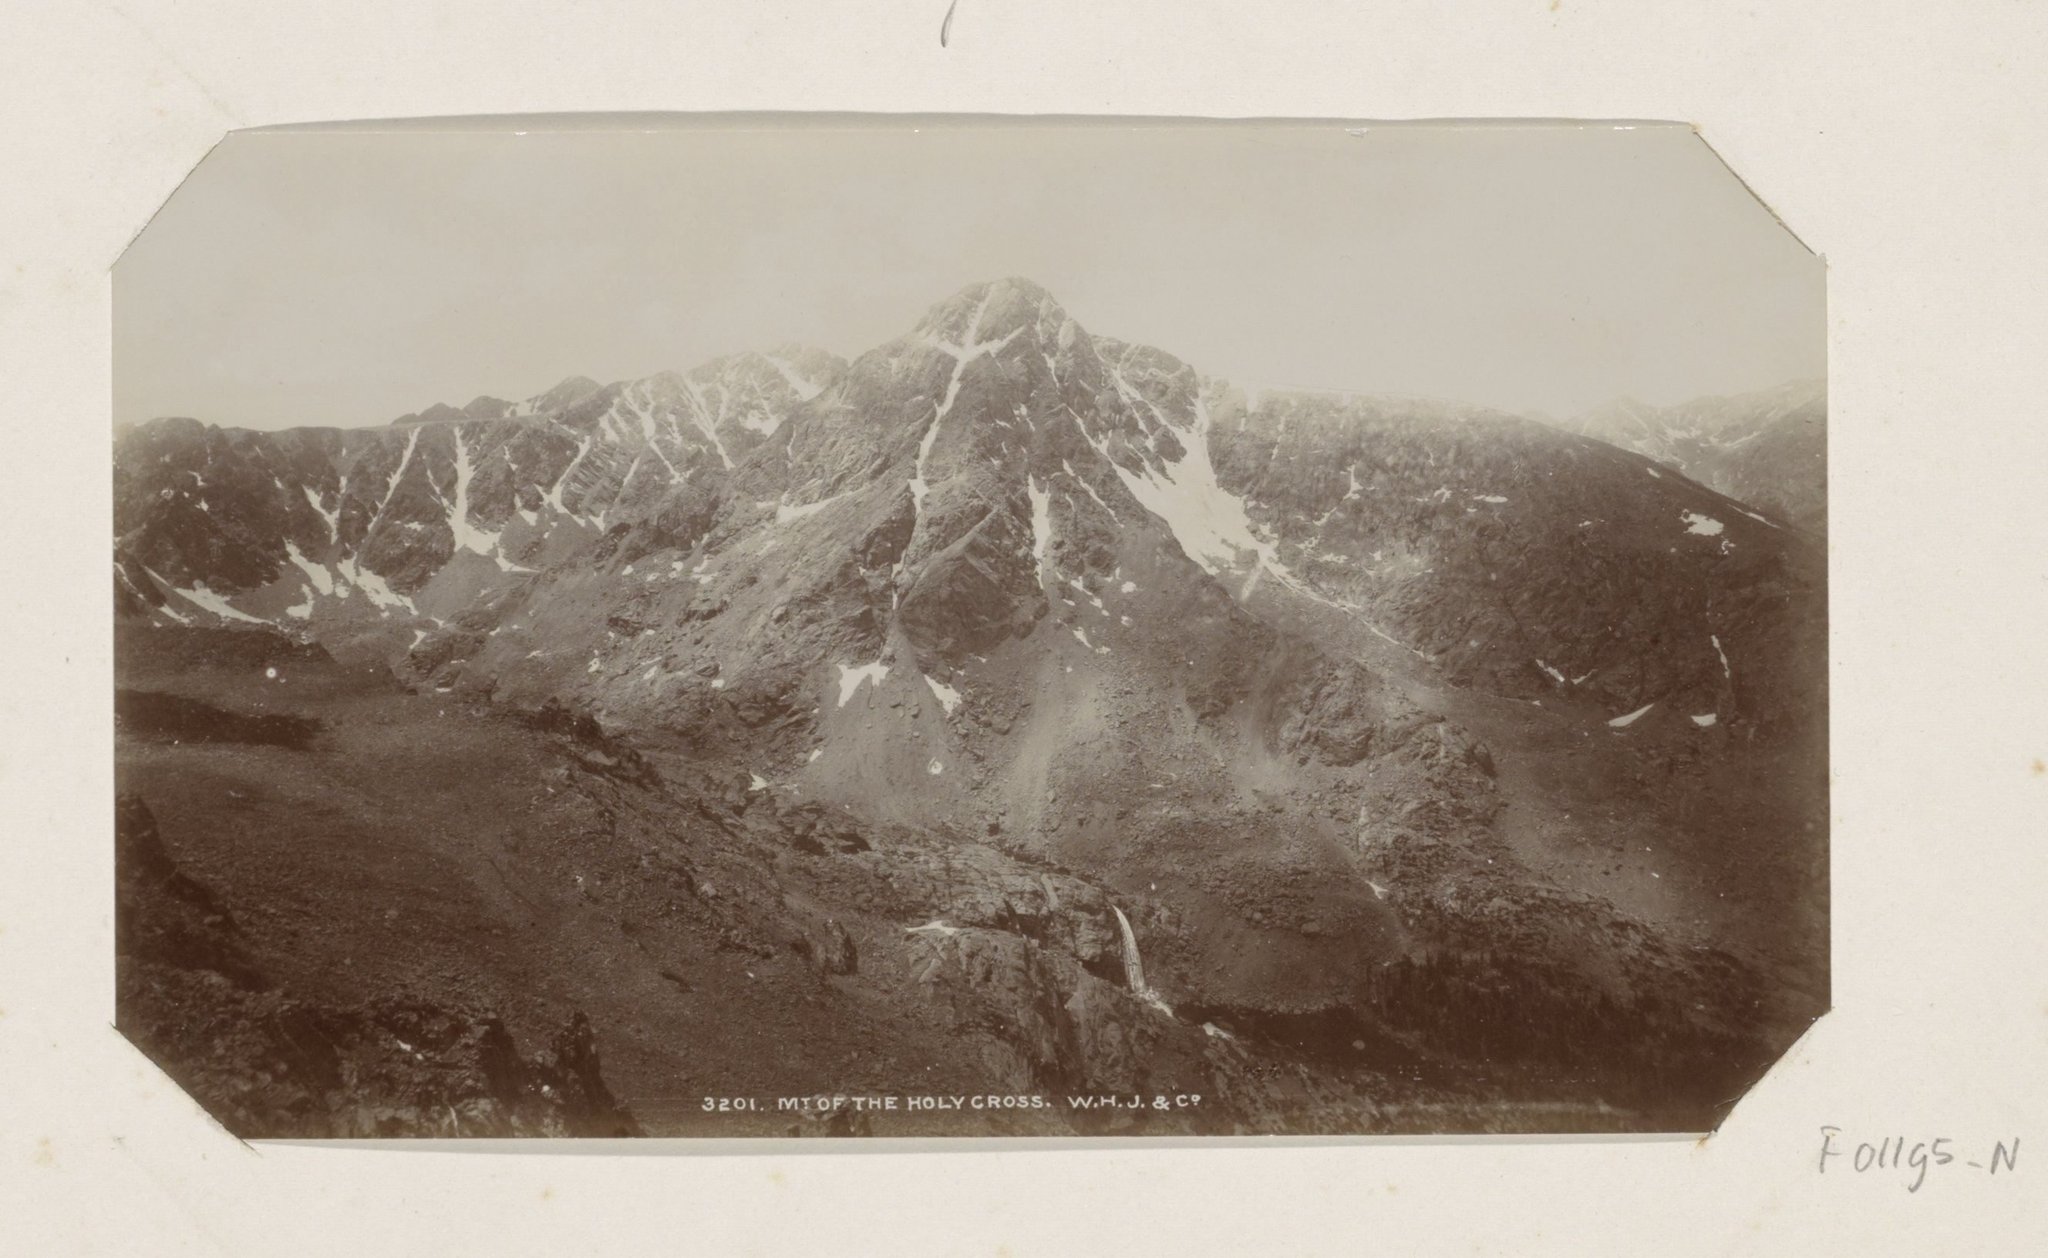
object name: photograph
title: Mt. of the Holy Cross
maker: william henry jackson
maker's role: fotograaf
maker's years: 1843-1942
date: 1860-1900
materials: cardboard, paper, photographic support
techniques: gelatin silver print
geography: rocky mountains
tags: mountain-range, snow peaks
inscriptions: negative number: ‘3201’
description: Onderdeel van Fotoalbum van een reis door de Verenigde Staten, Honolulu, Nederlands-Indië, Aden, Zanzibar en Zuidelijk Afrika.